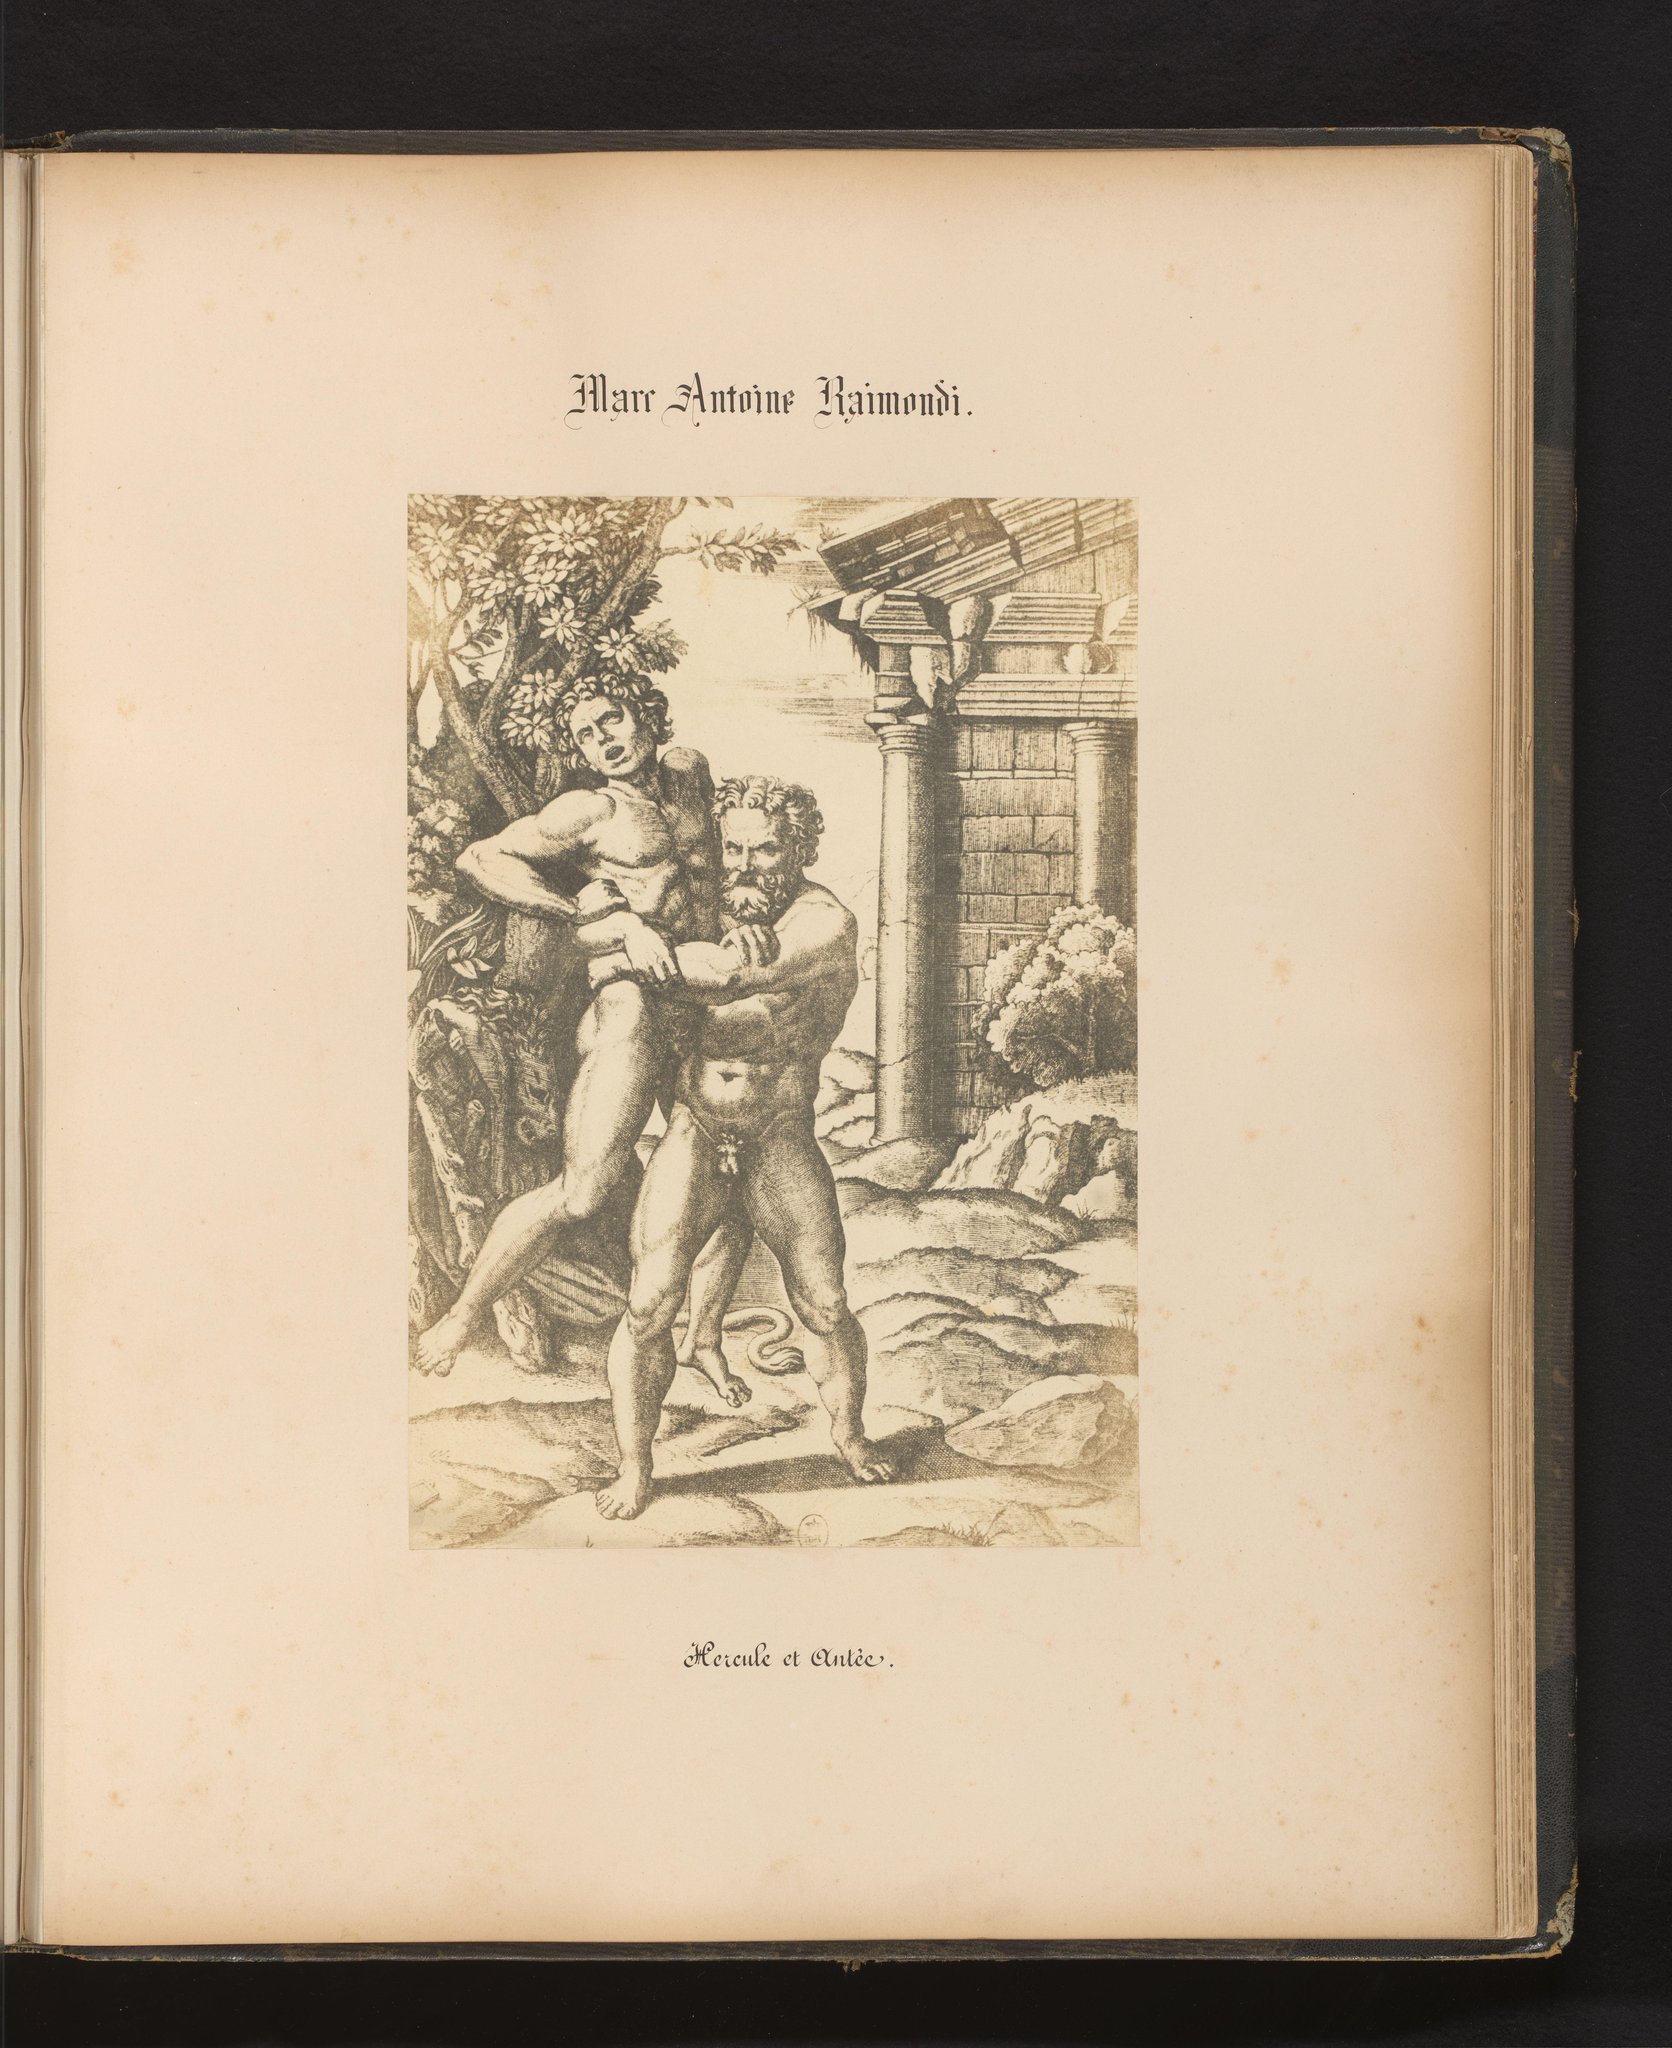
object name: reproduction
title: Marc Antoine Raimondi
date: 1848-1853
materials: photographic support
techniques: salted paper print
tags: the giant antaeus is lifted in the air and crushed to death by hercules